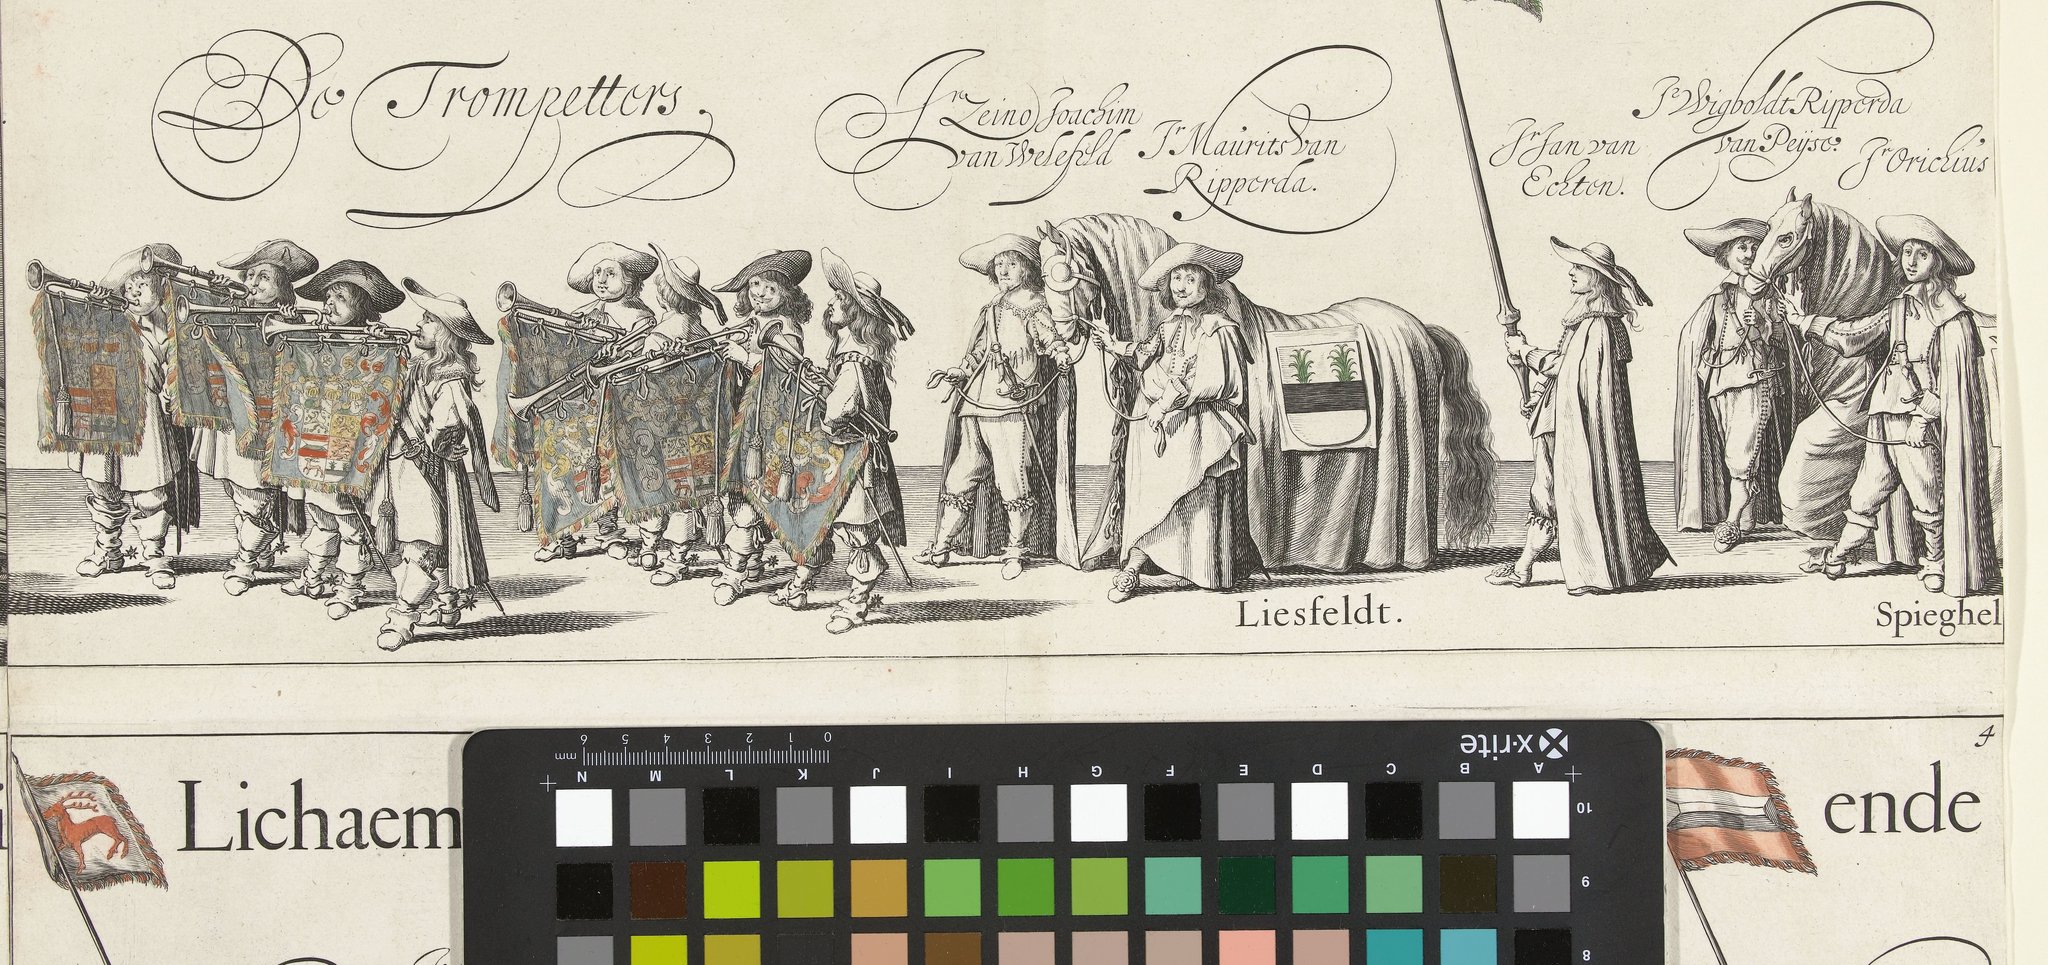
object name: print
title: Deel van de begrafenisstoet van Ernst Casimir, graaf van Nassau-Dietz te Leeuwarden (plaat 3), 1633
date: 1634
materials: paper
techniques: engraving, etching, hand coloring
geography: northern netherlands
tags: ernst casimir graaf van nassau-dietz, cortege, funeral procession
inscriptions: date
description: Deel van de begrafenisstoet met trompetters, paard en vaandeldrager. Bovenin de namen van de afgebeelde personen. Plaat nr. 3 in de prentserie van de begrafenis van Ernst Casimir, graaf van Nassau-Dietz te Leeuwarden, 3 januari 1633. De wapens en vaandels zijn ingekleurd. Dit blad samen met bladen 1, 2 en 4 aan elkaar geplakt.